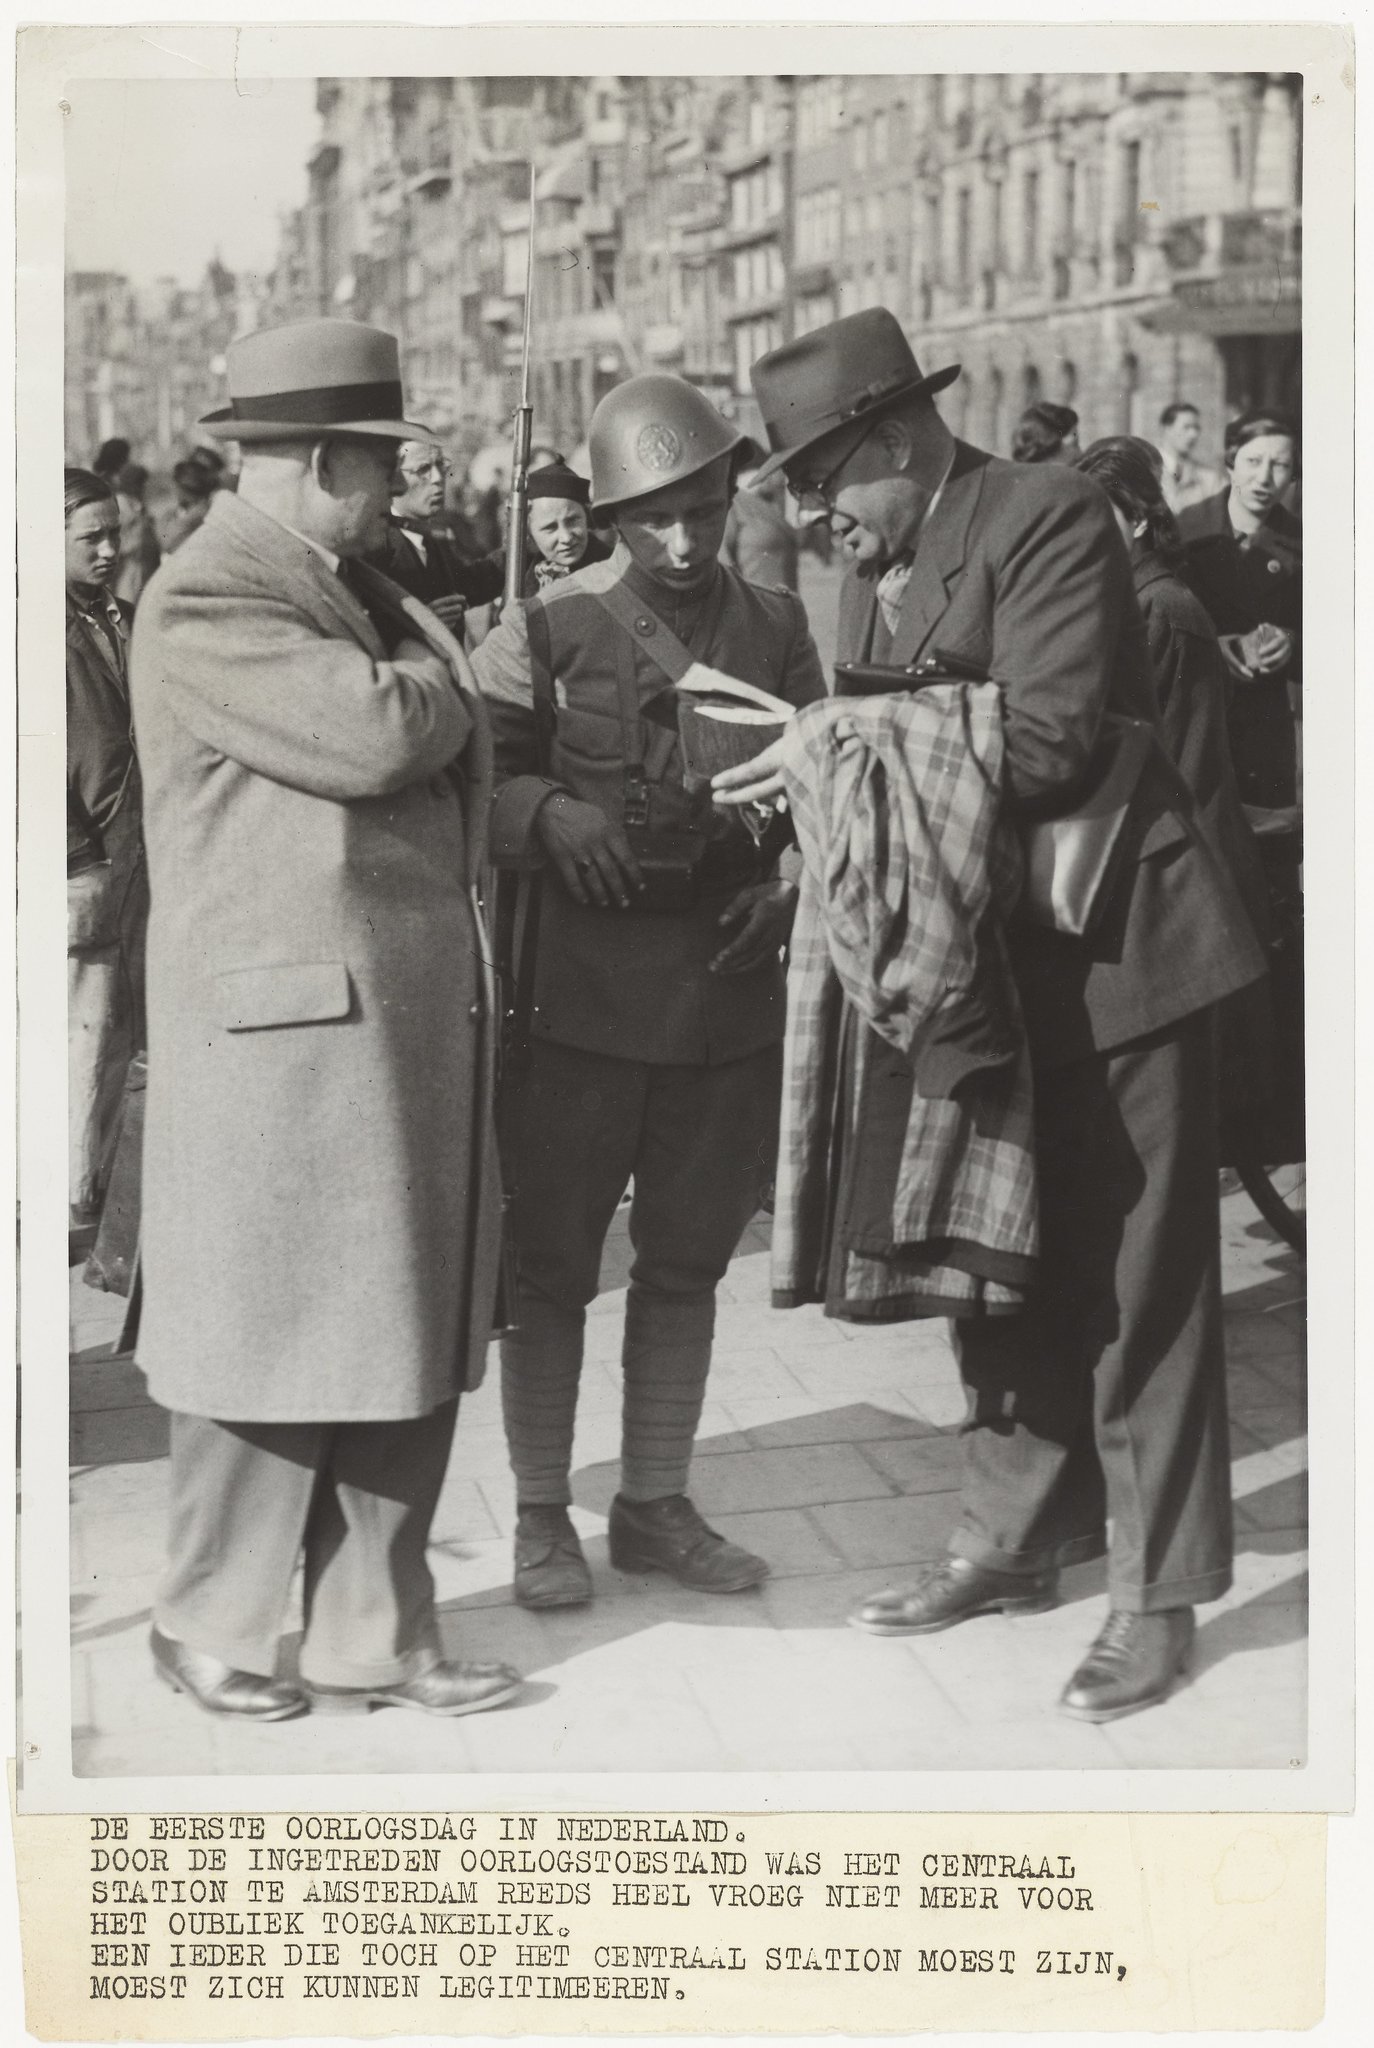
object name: photograph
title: Eerste oorlogsdag bij het Centraal Station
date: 1940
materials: photographic support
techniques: photography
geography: damrak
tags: occupier and civilians, amsterdam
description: Op de eerste dag van de oorlog was het Centraal Station niet toegangkelijk voor het publiek. Iedereen die er echt moest zijn moest zich legitimeren bij een Nederlandse soldaat. Tekststrookje aan foto geplakt.